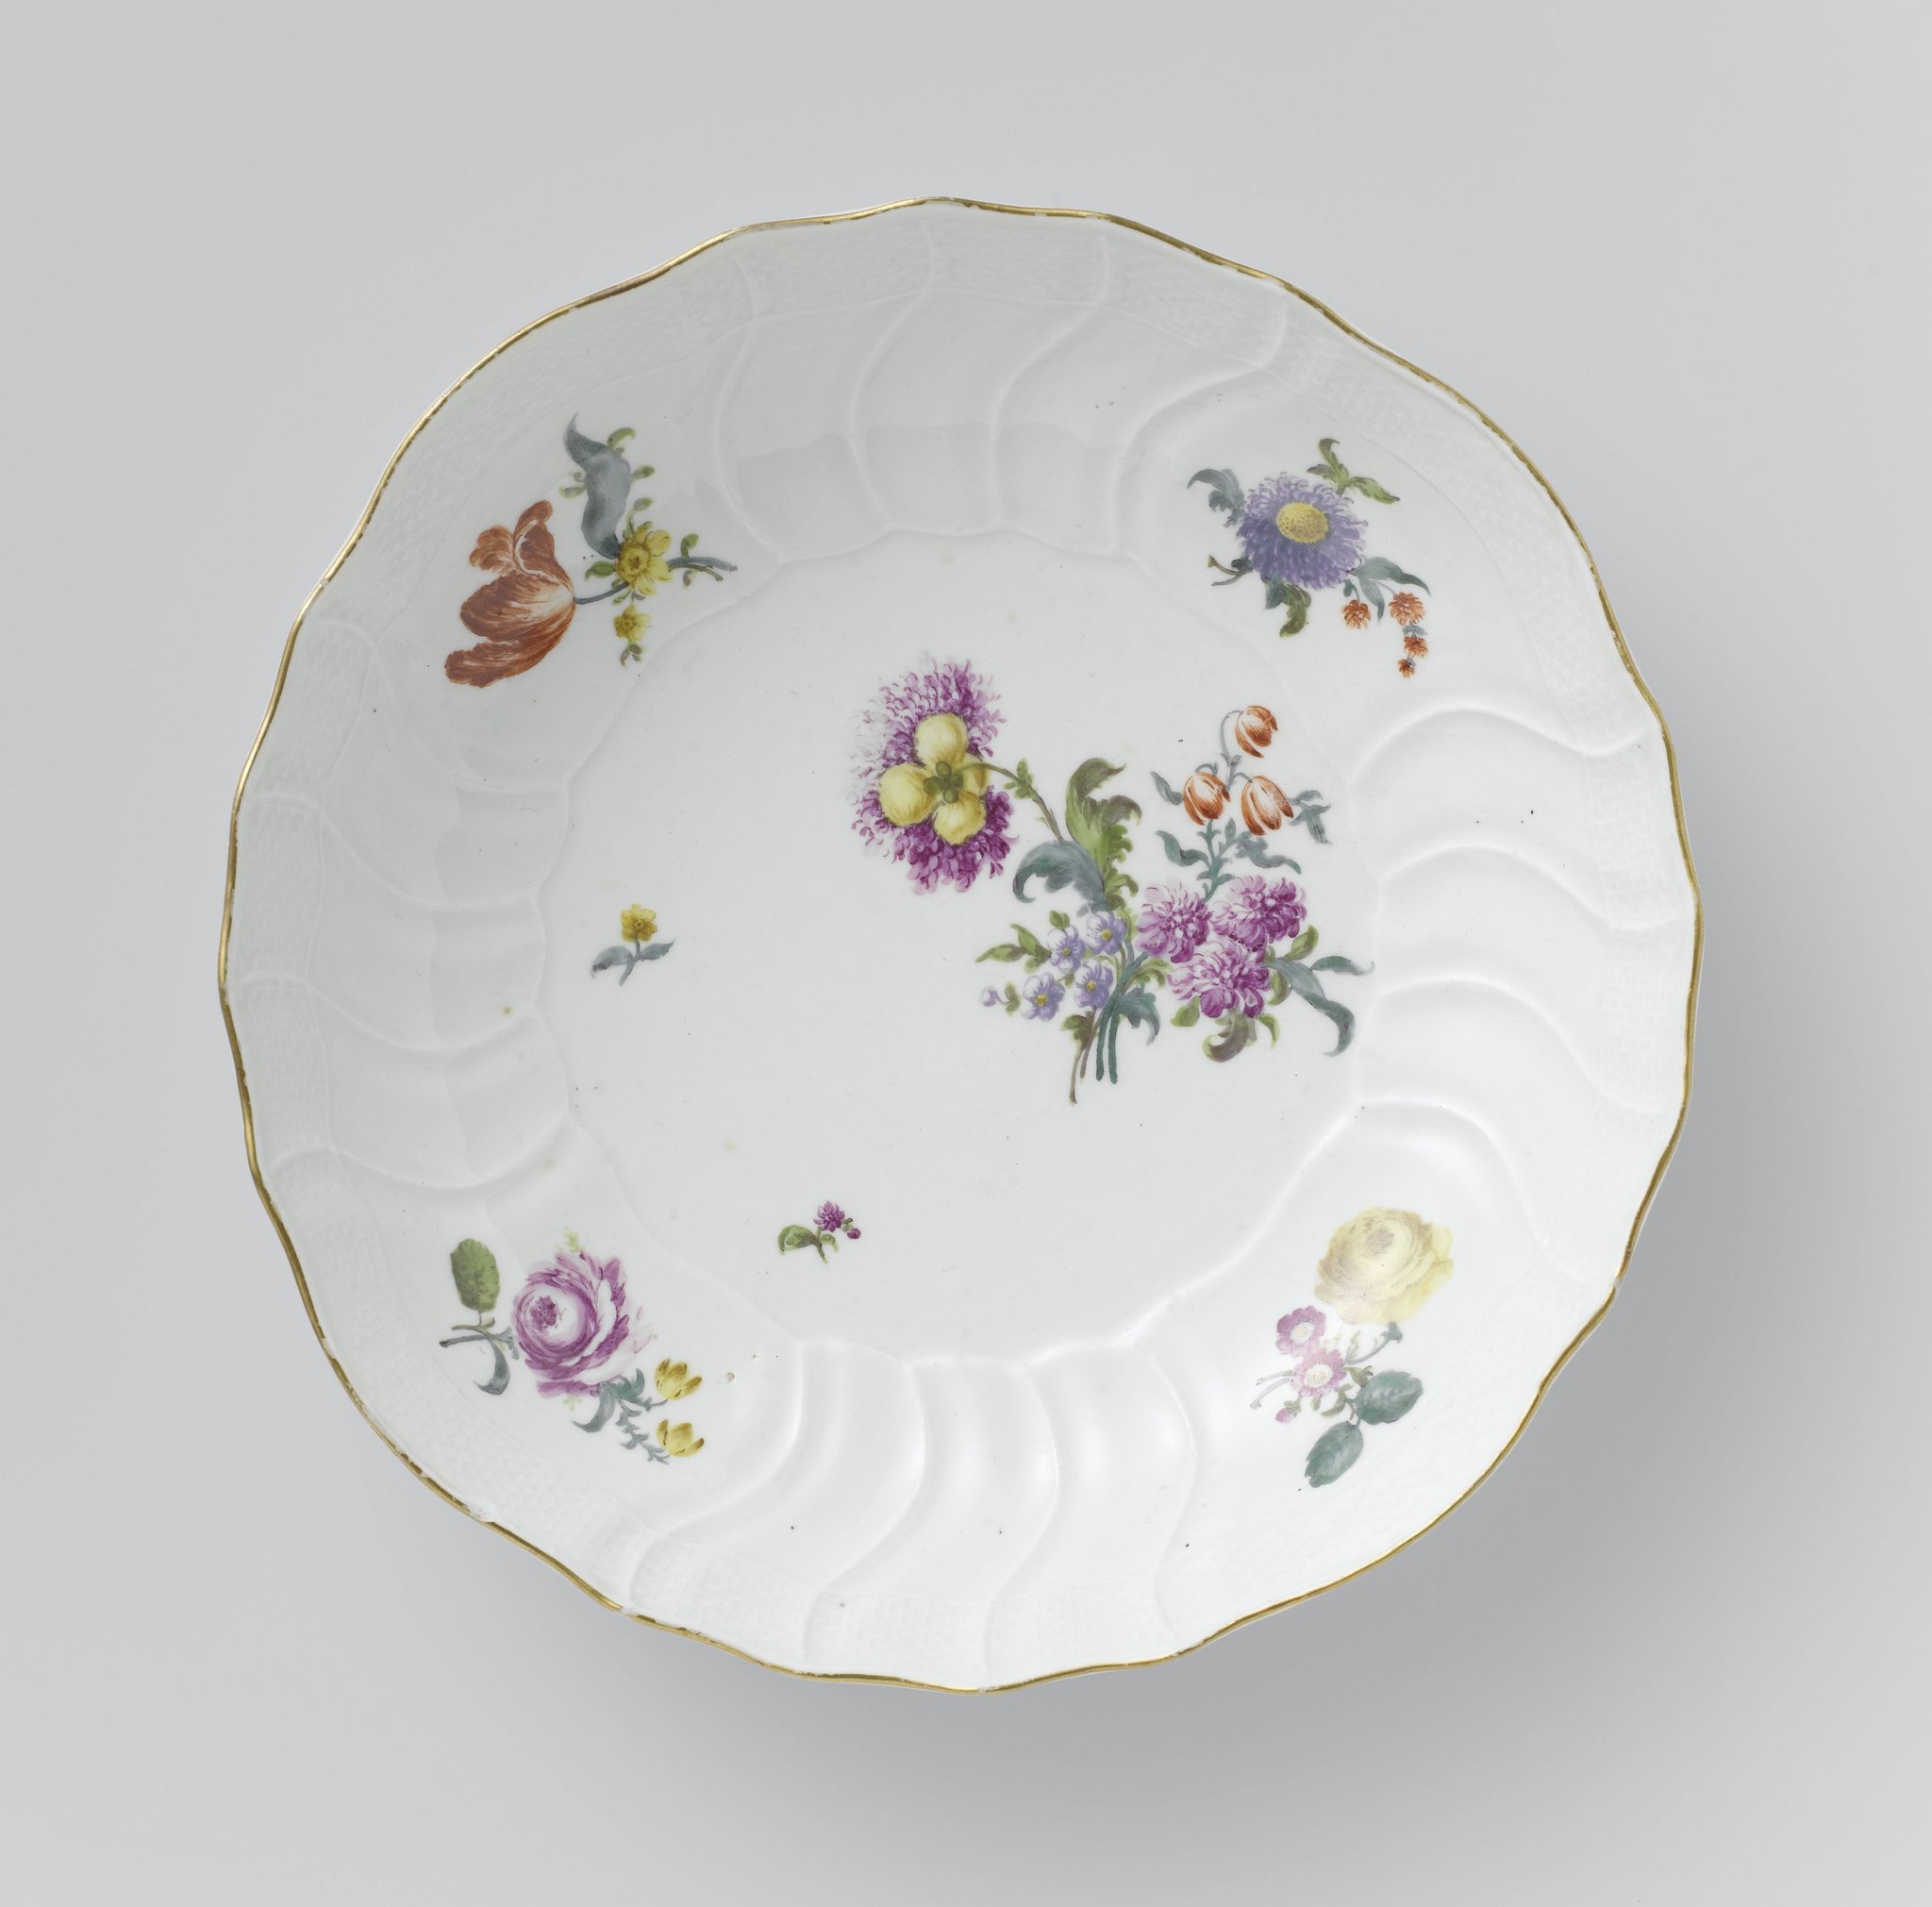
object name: eating drinking utensil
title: Schotel, veelkleurig beschilderd met Deutsche Blumen, insekten en vruchten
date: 1750-1760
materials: porcelain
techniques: painted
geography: meissen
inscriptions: factory mark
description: Ronde schotel van beschilderd porselein. De schotel is beschilderd met Deutsche Blumen, insekten en vruchten. De rand is in reliëf versierd met het Neuozier-patroon. De schotel is gemerkt en hoort bij een servies (BK-17474-1 t/m BK-17474-253).